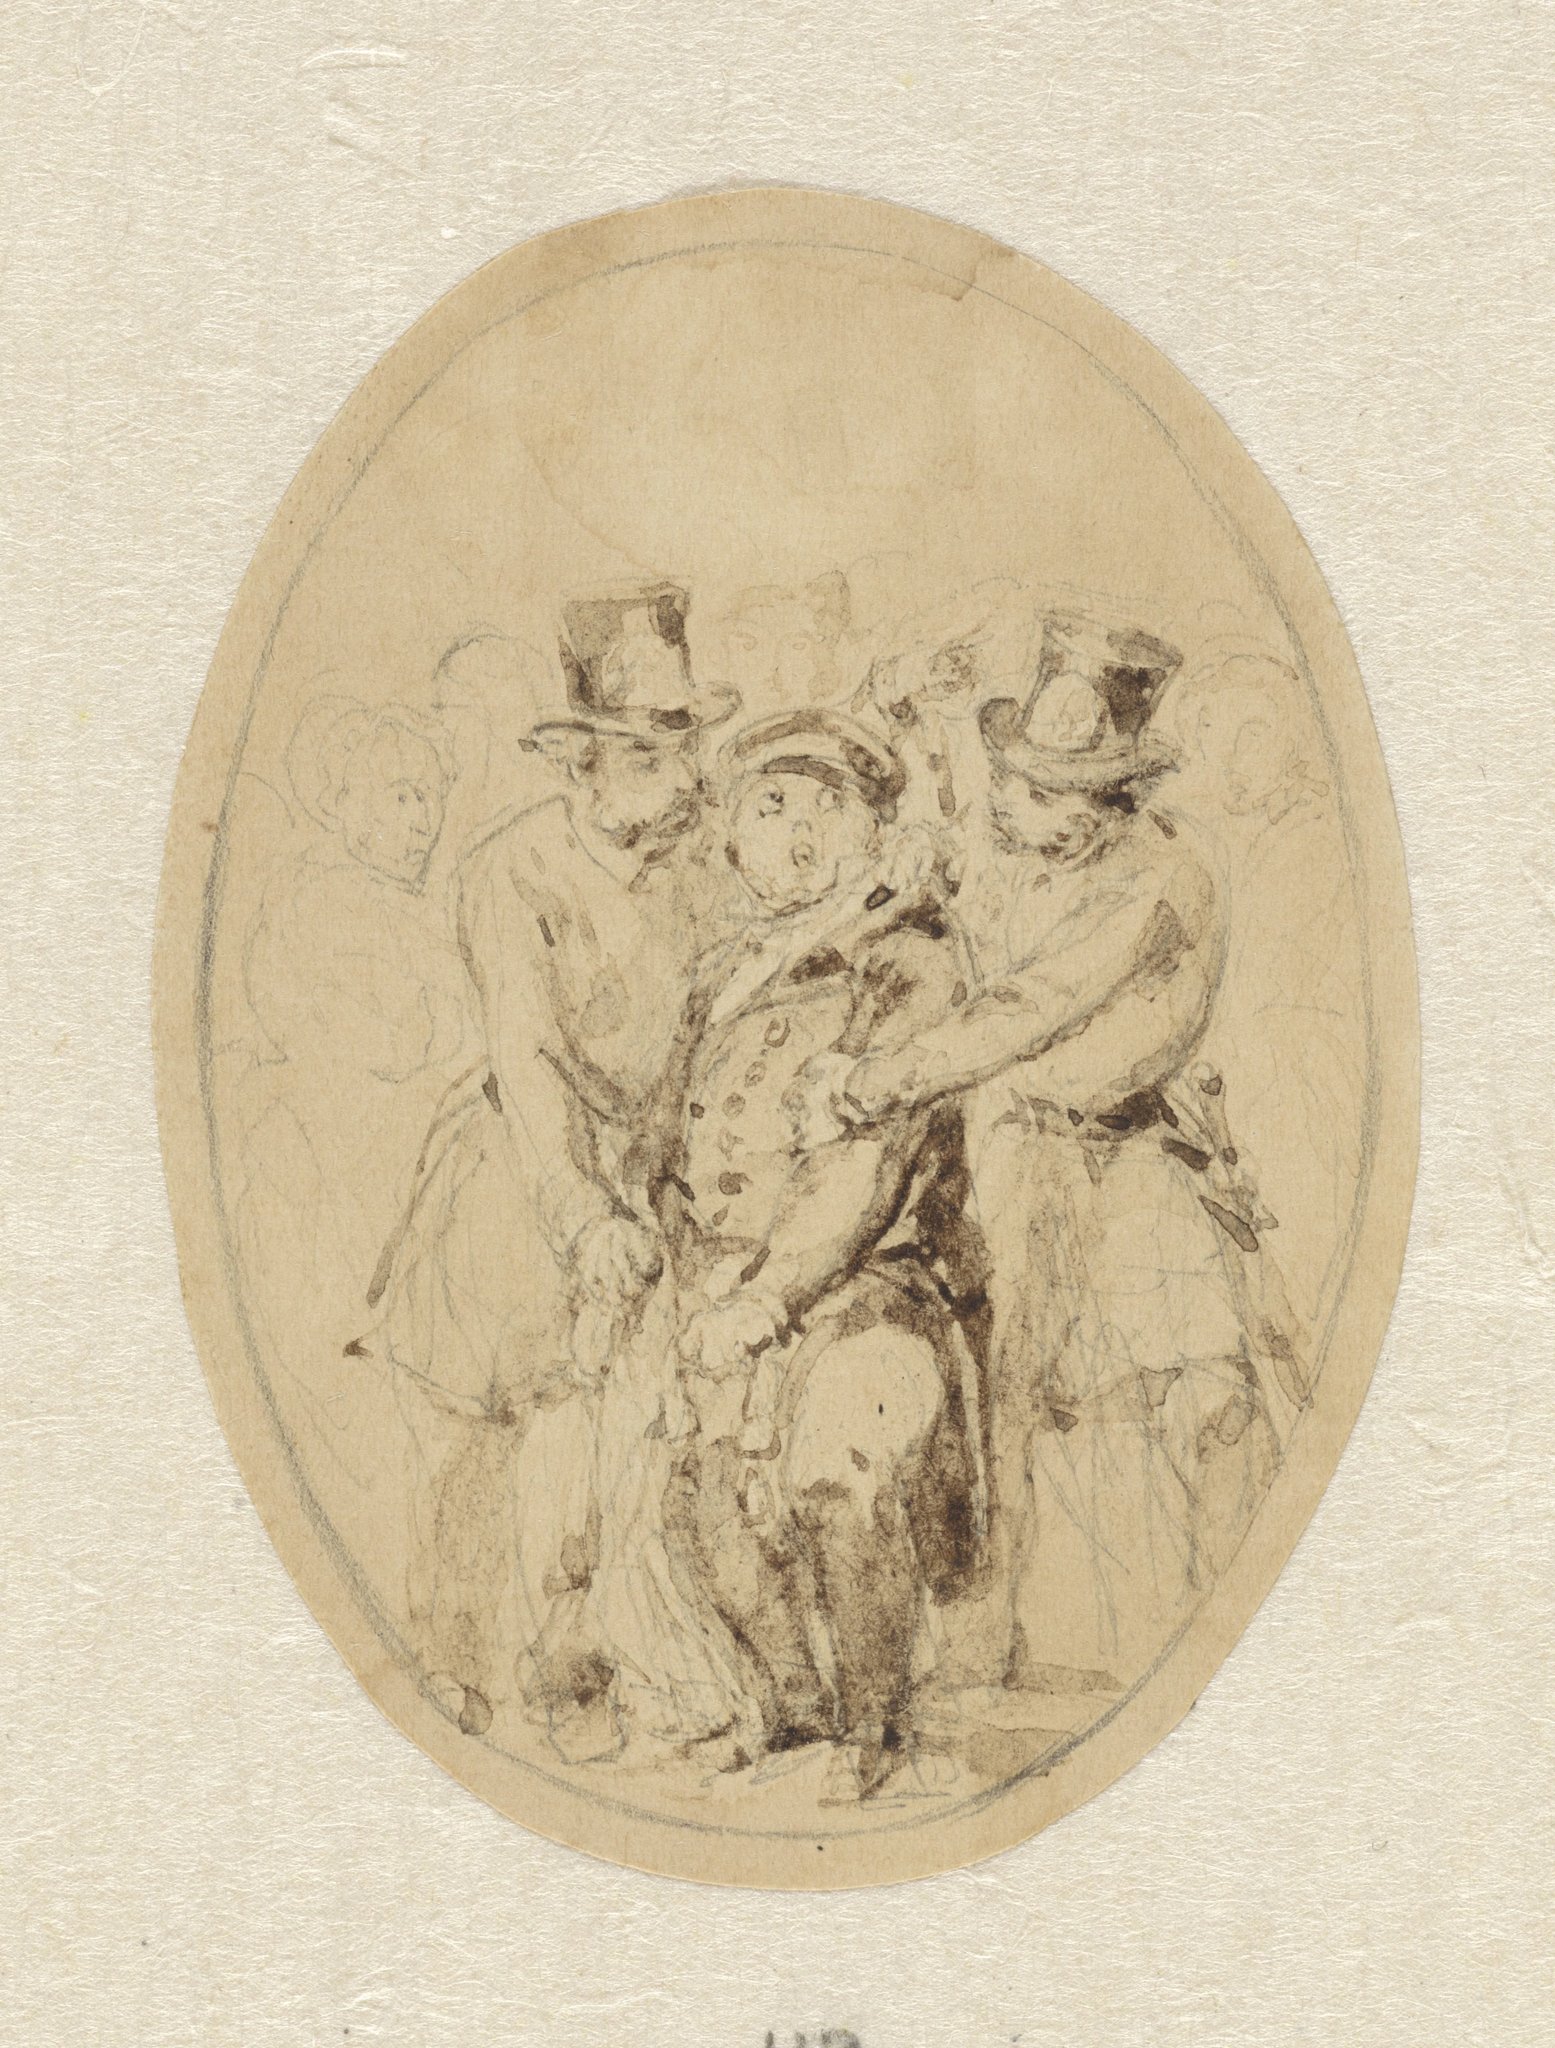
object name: drawing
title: Man wordt opgebracht door twee heren in burger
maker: herman frederik carel ten kate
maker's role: draughtsman, painter, print maker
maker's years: 1822-1891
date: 1832-1891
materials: paper, pencil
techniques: brush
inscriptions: inscription: ‘II’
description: Boekillustratie voor roman uitgegeven door A.C. Kruseman te Haarlem, no.II (?)